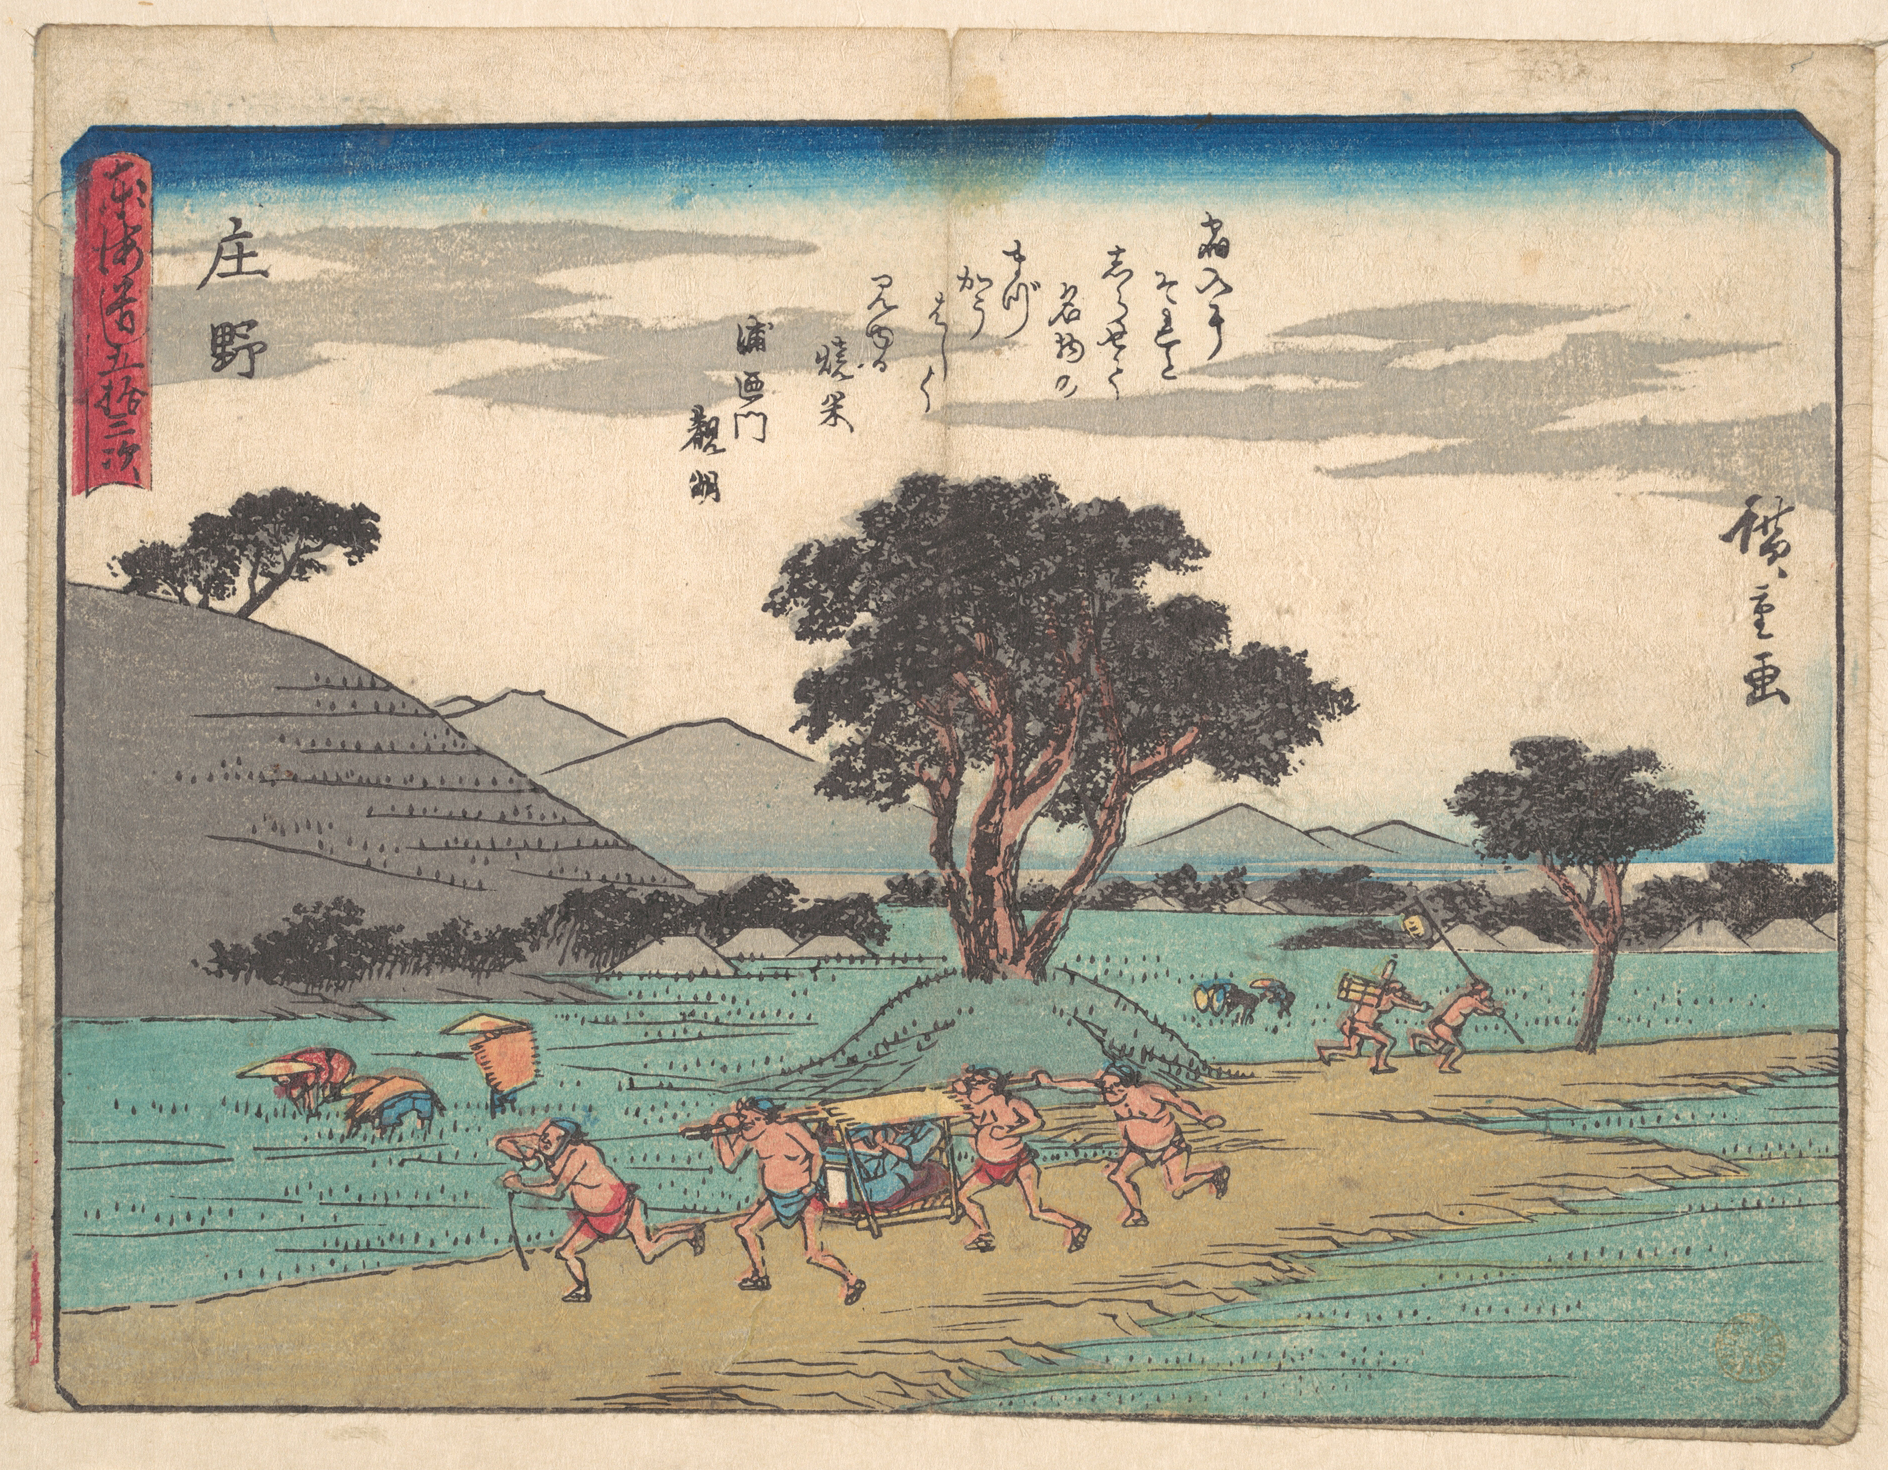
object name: print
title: Shono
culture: japanese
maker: utagawa hiroshige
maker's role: artist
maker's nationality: japanese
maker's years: 1797-1858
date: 1838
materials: ink, paper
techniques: woodblock print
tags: human figures,hills,trees,farmers